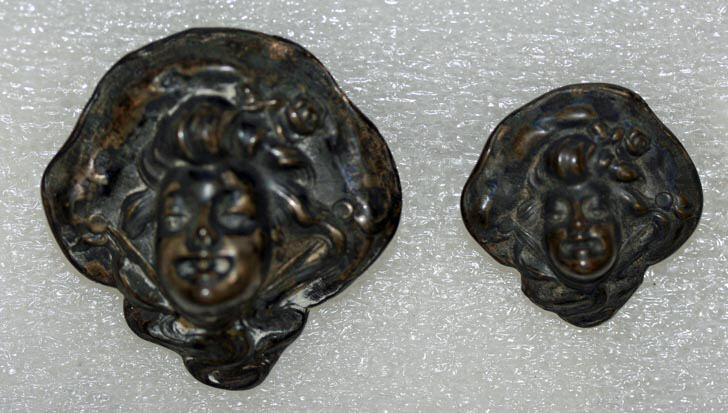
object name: button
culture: american or european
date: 1880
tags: faces